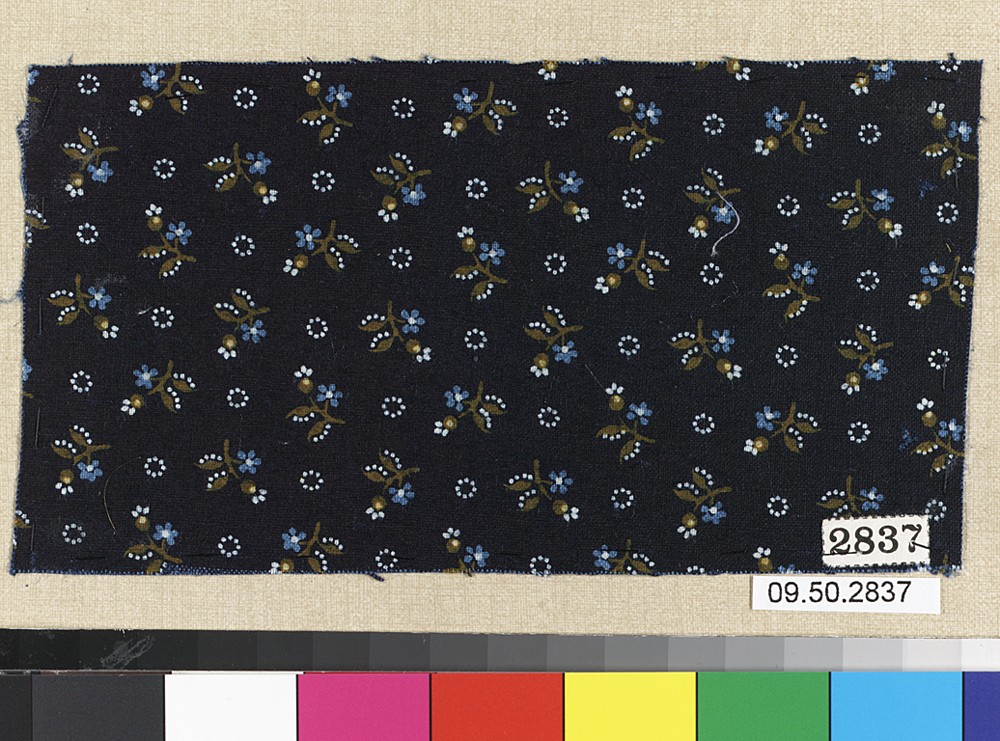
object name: piece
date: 1801-1900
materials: cotton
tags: flowers,leaves